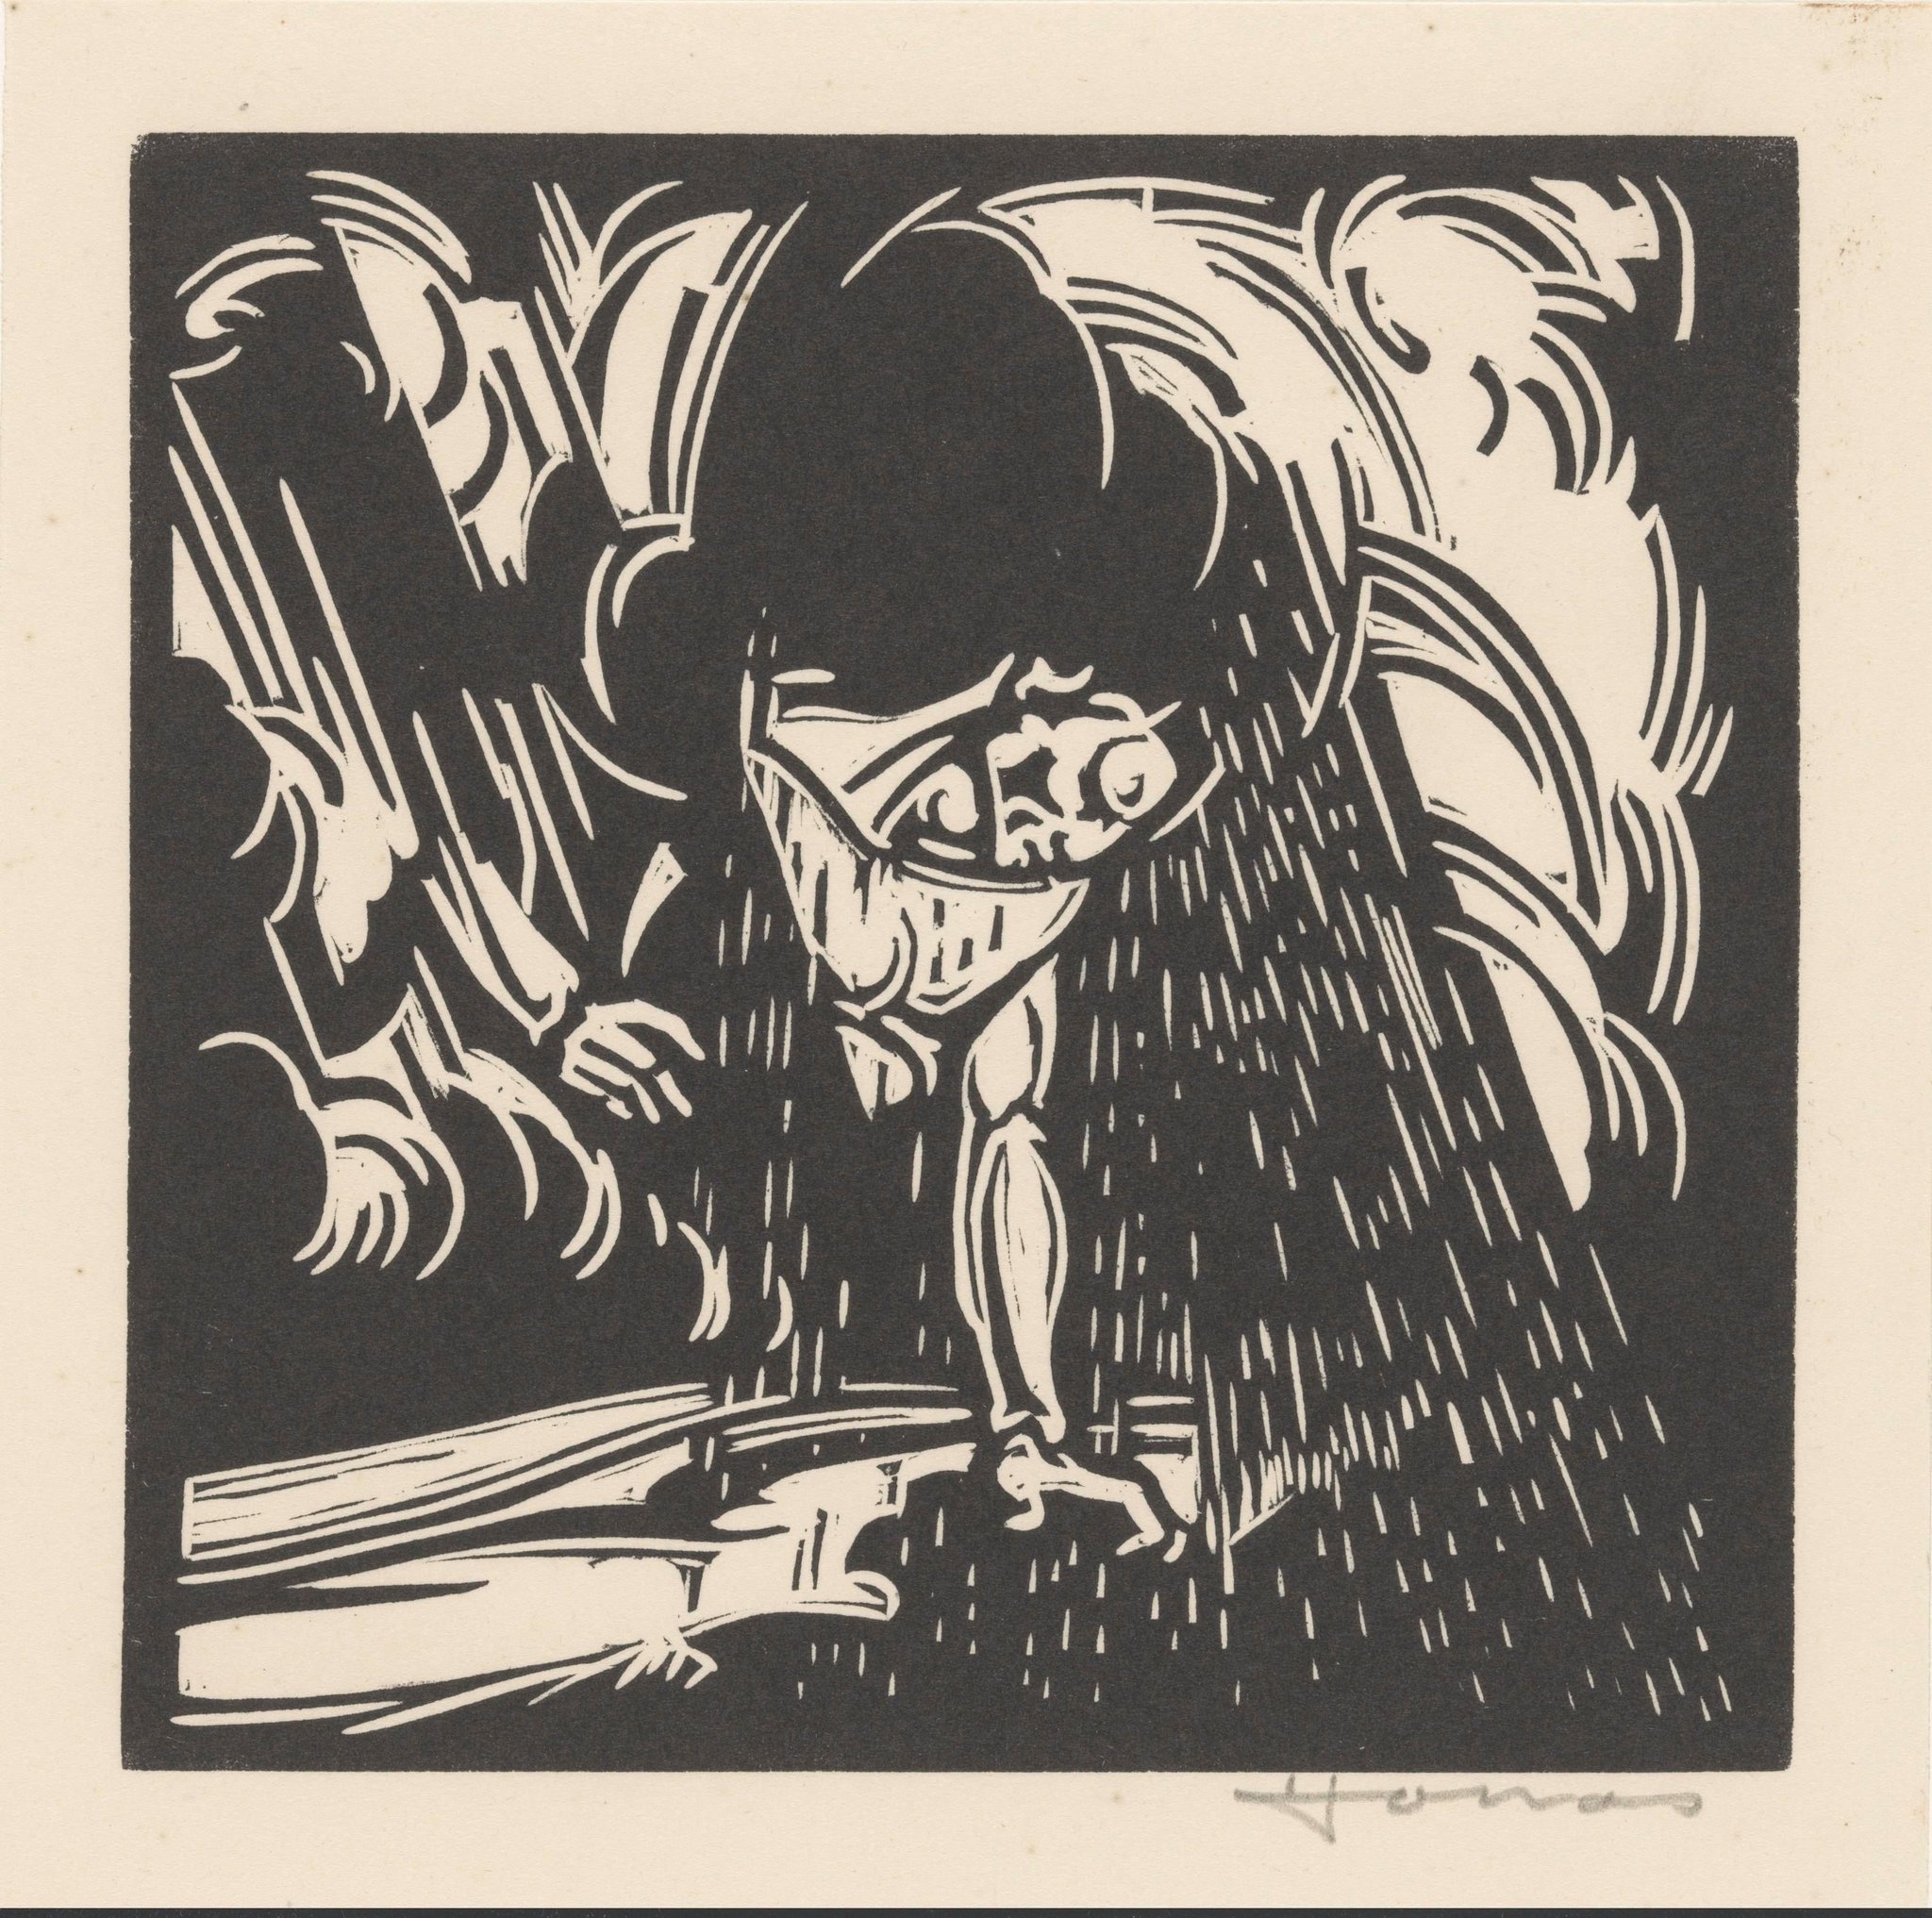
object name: print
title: Personificatie van de regen boven een landschap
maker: henri jonas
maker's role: draughtsman, print maker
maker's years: 1878-1944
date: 1921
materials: paper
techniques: woodcut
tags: downpour, rain shower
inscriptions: collector's mark: Lugt 2228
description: Prent gebruikt voor: Kemp, Mathias. De zeven broeders. Maastricht: Leiter-Nypels, 1921.